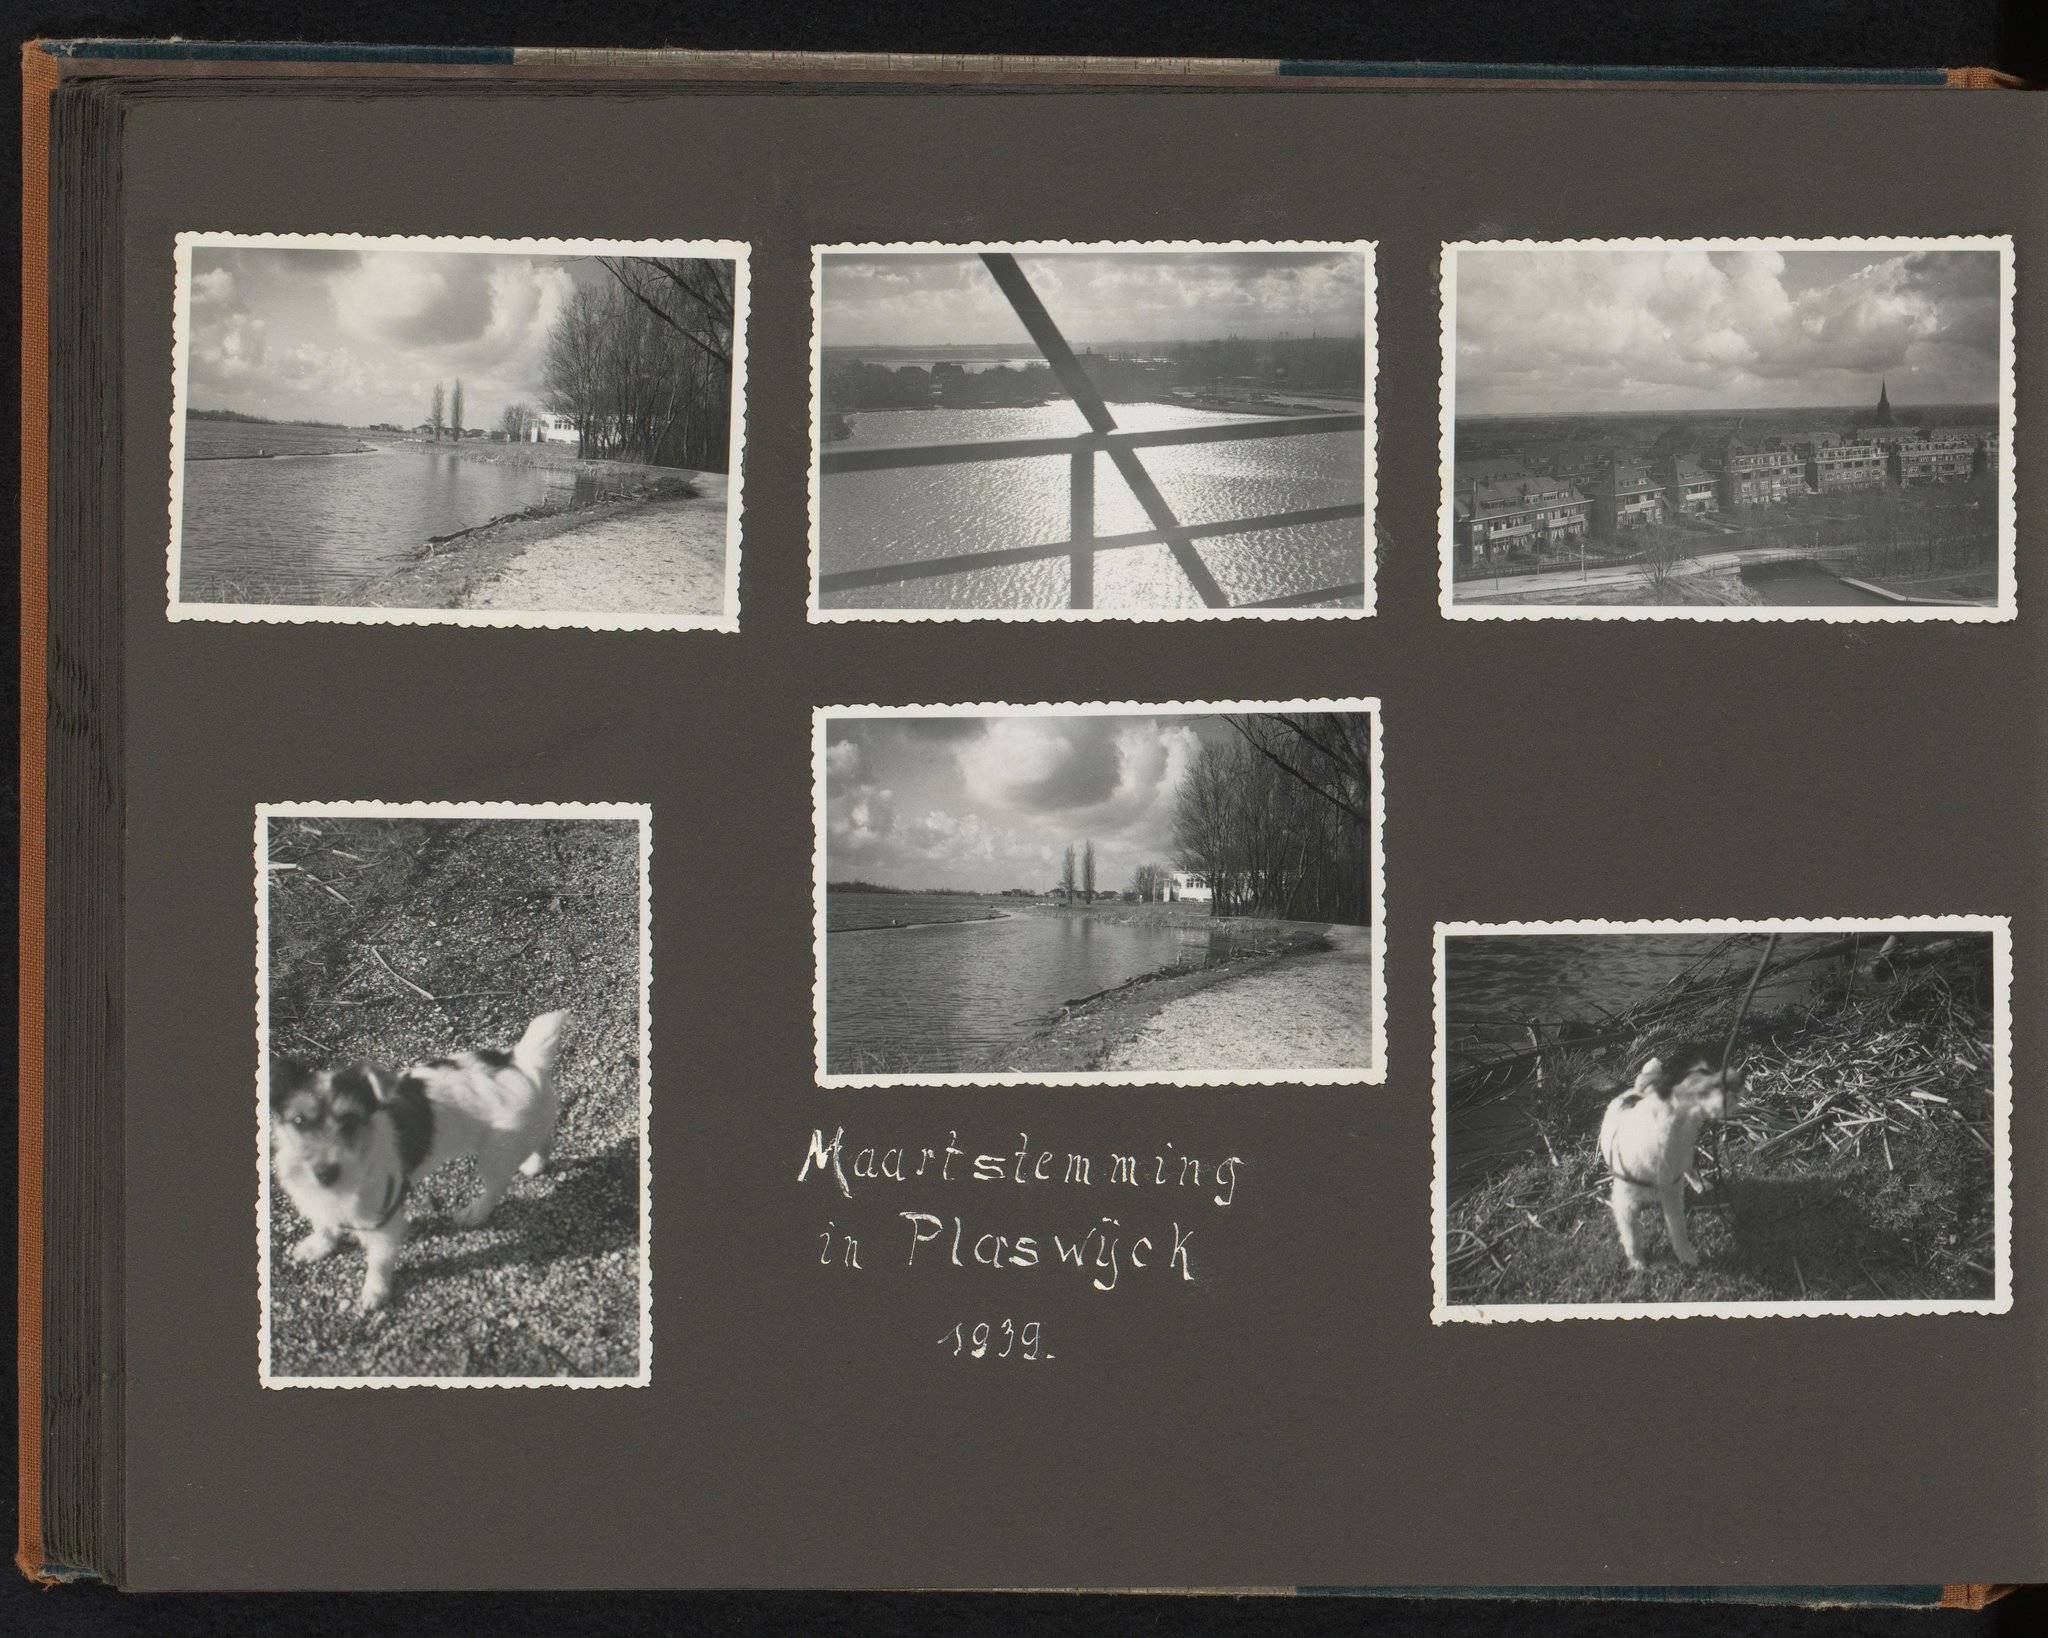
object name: photograph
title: Gezichten op Rotterdam en de hond Bessie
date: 1903-1939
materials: cardboard, paper, photographic support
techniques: gelatin silver print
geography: rotterdam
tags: city-view in general; 'veduta', landscapes with waters, waterscapes, seascapes (in the temperate zone), walking the dog, interior of the house, rotterdam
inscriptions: date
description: Vier landschappen gemaakt in de omgeving van Rotterdam en twee foto's van hond Bessie. Deze pagina maakt deel uit van een album.